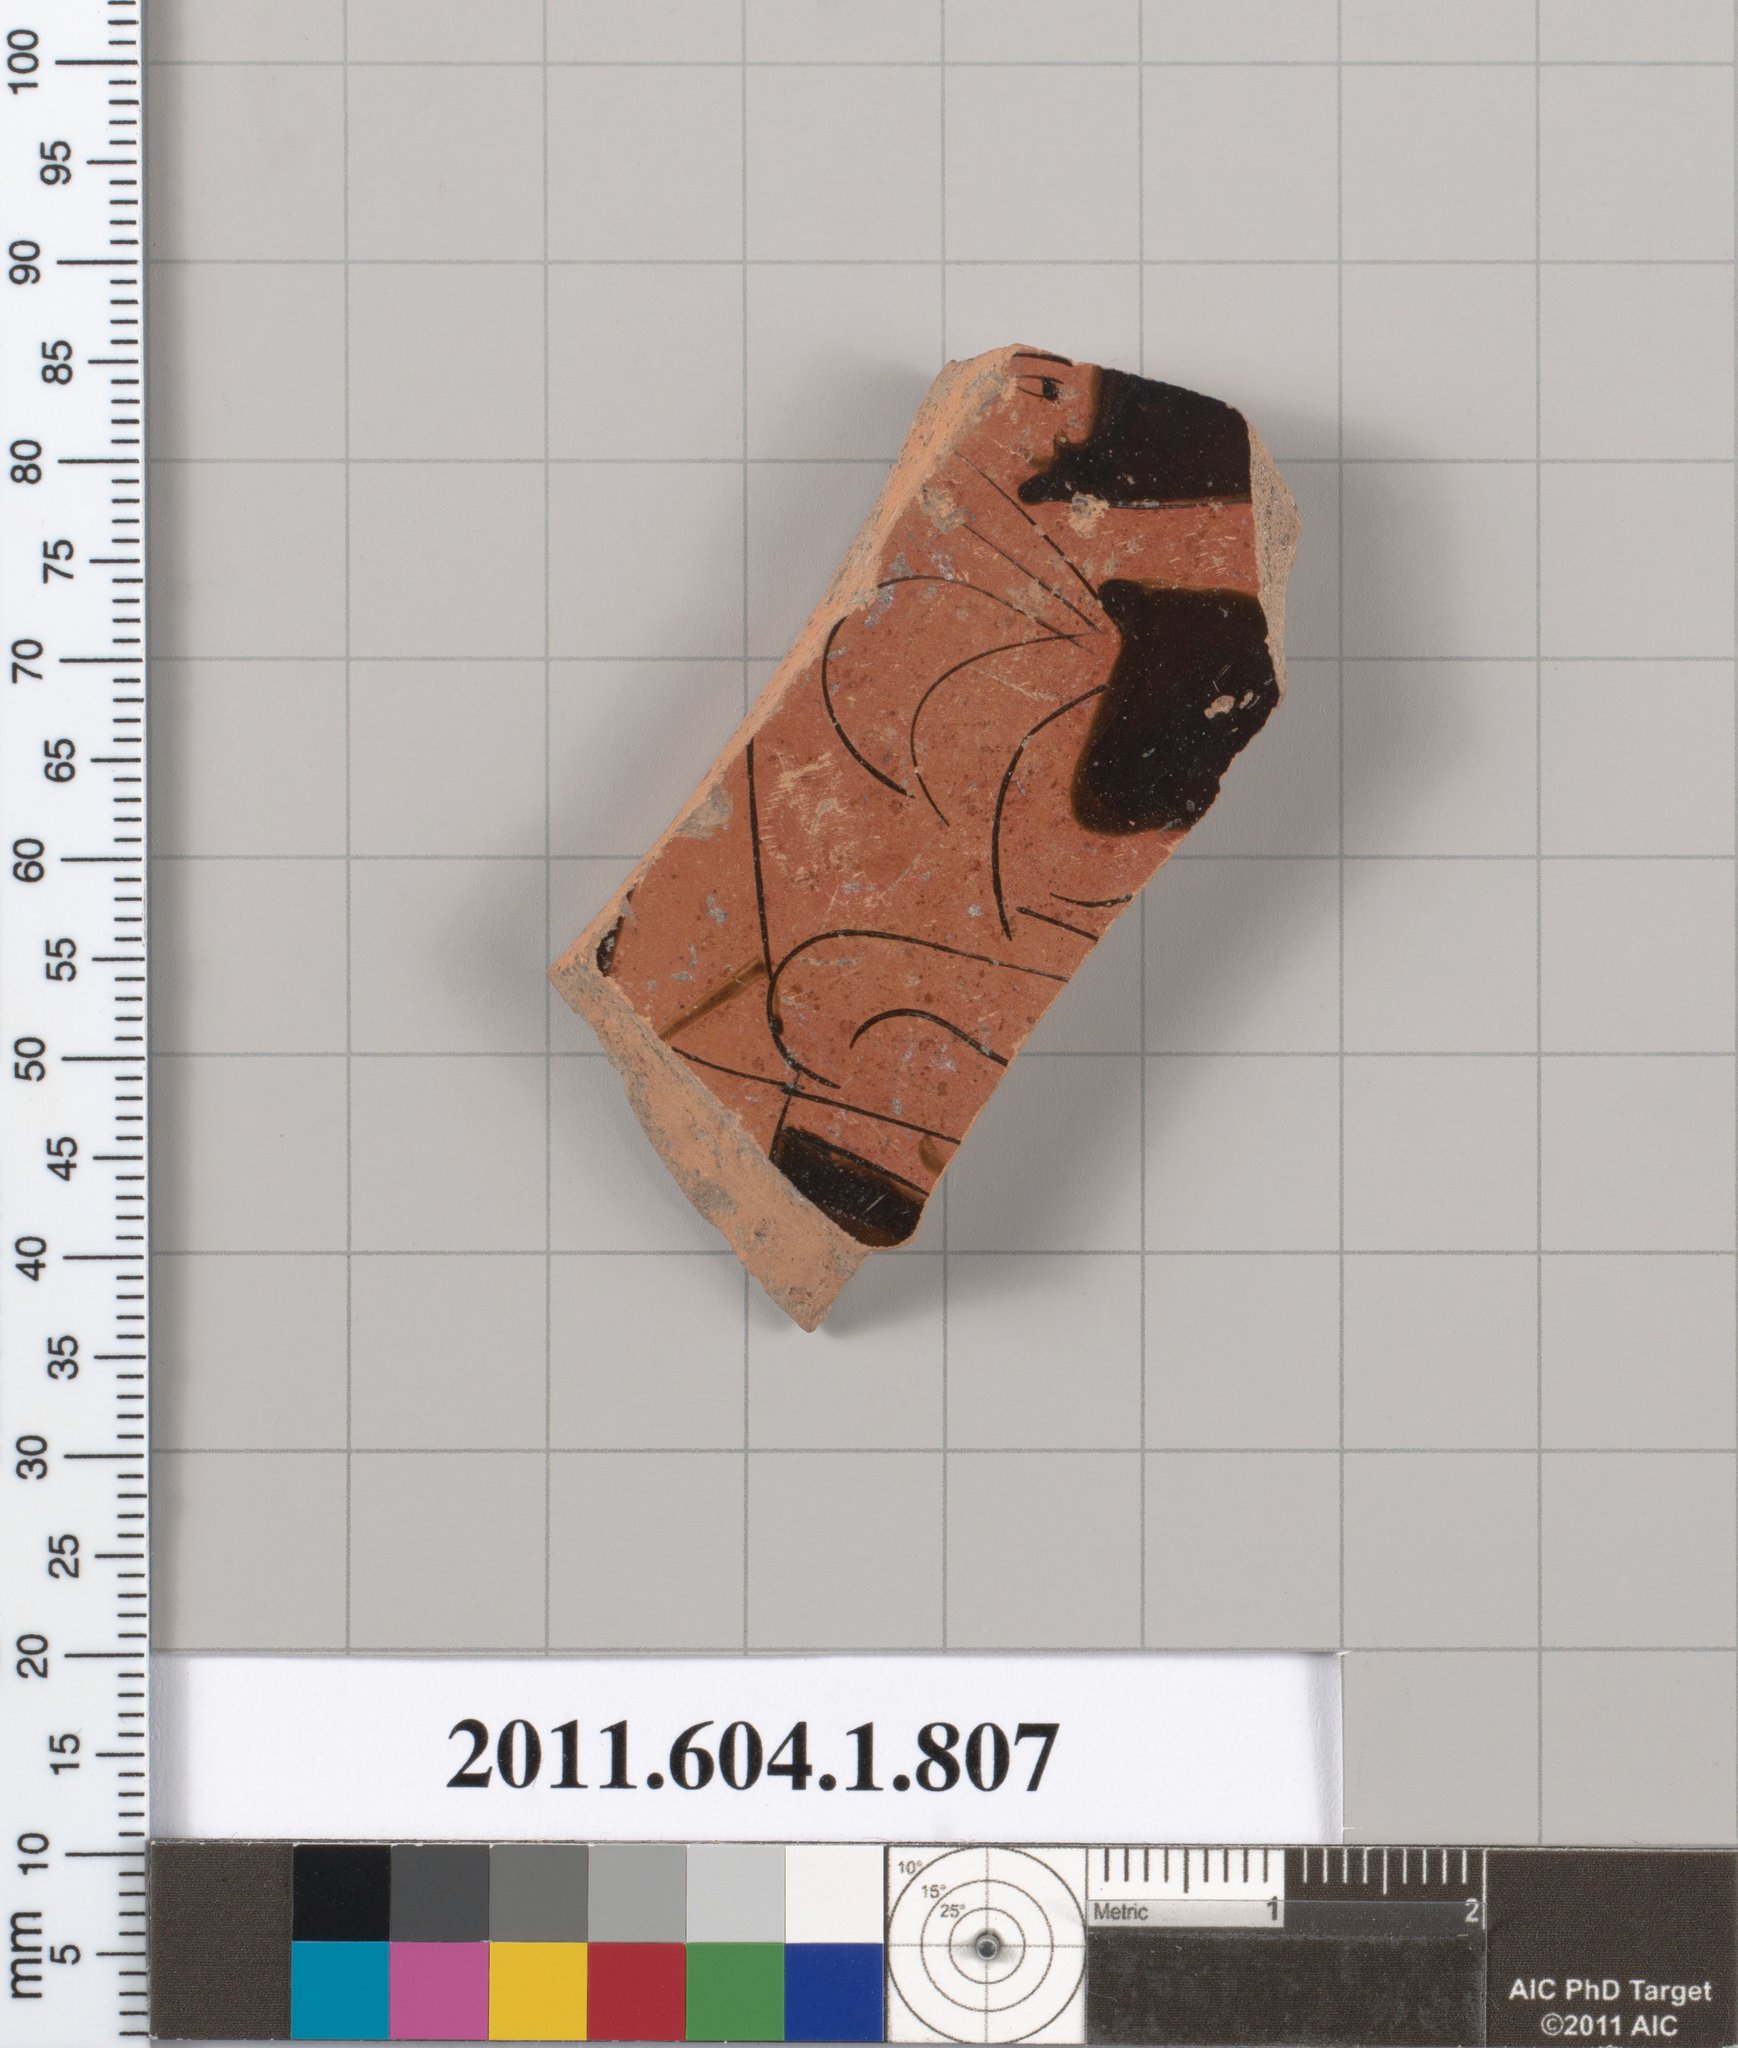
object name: kylix fragment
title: Terracotta fragment of a kylix (drinking cup)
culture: greek, attic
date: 475-451 BCE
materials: terracotta